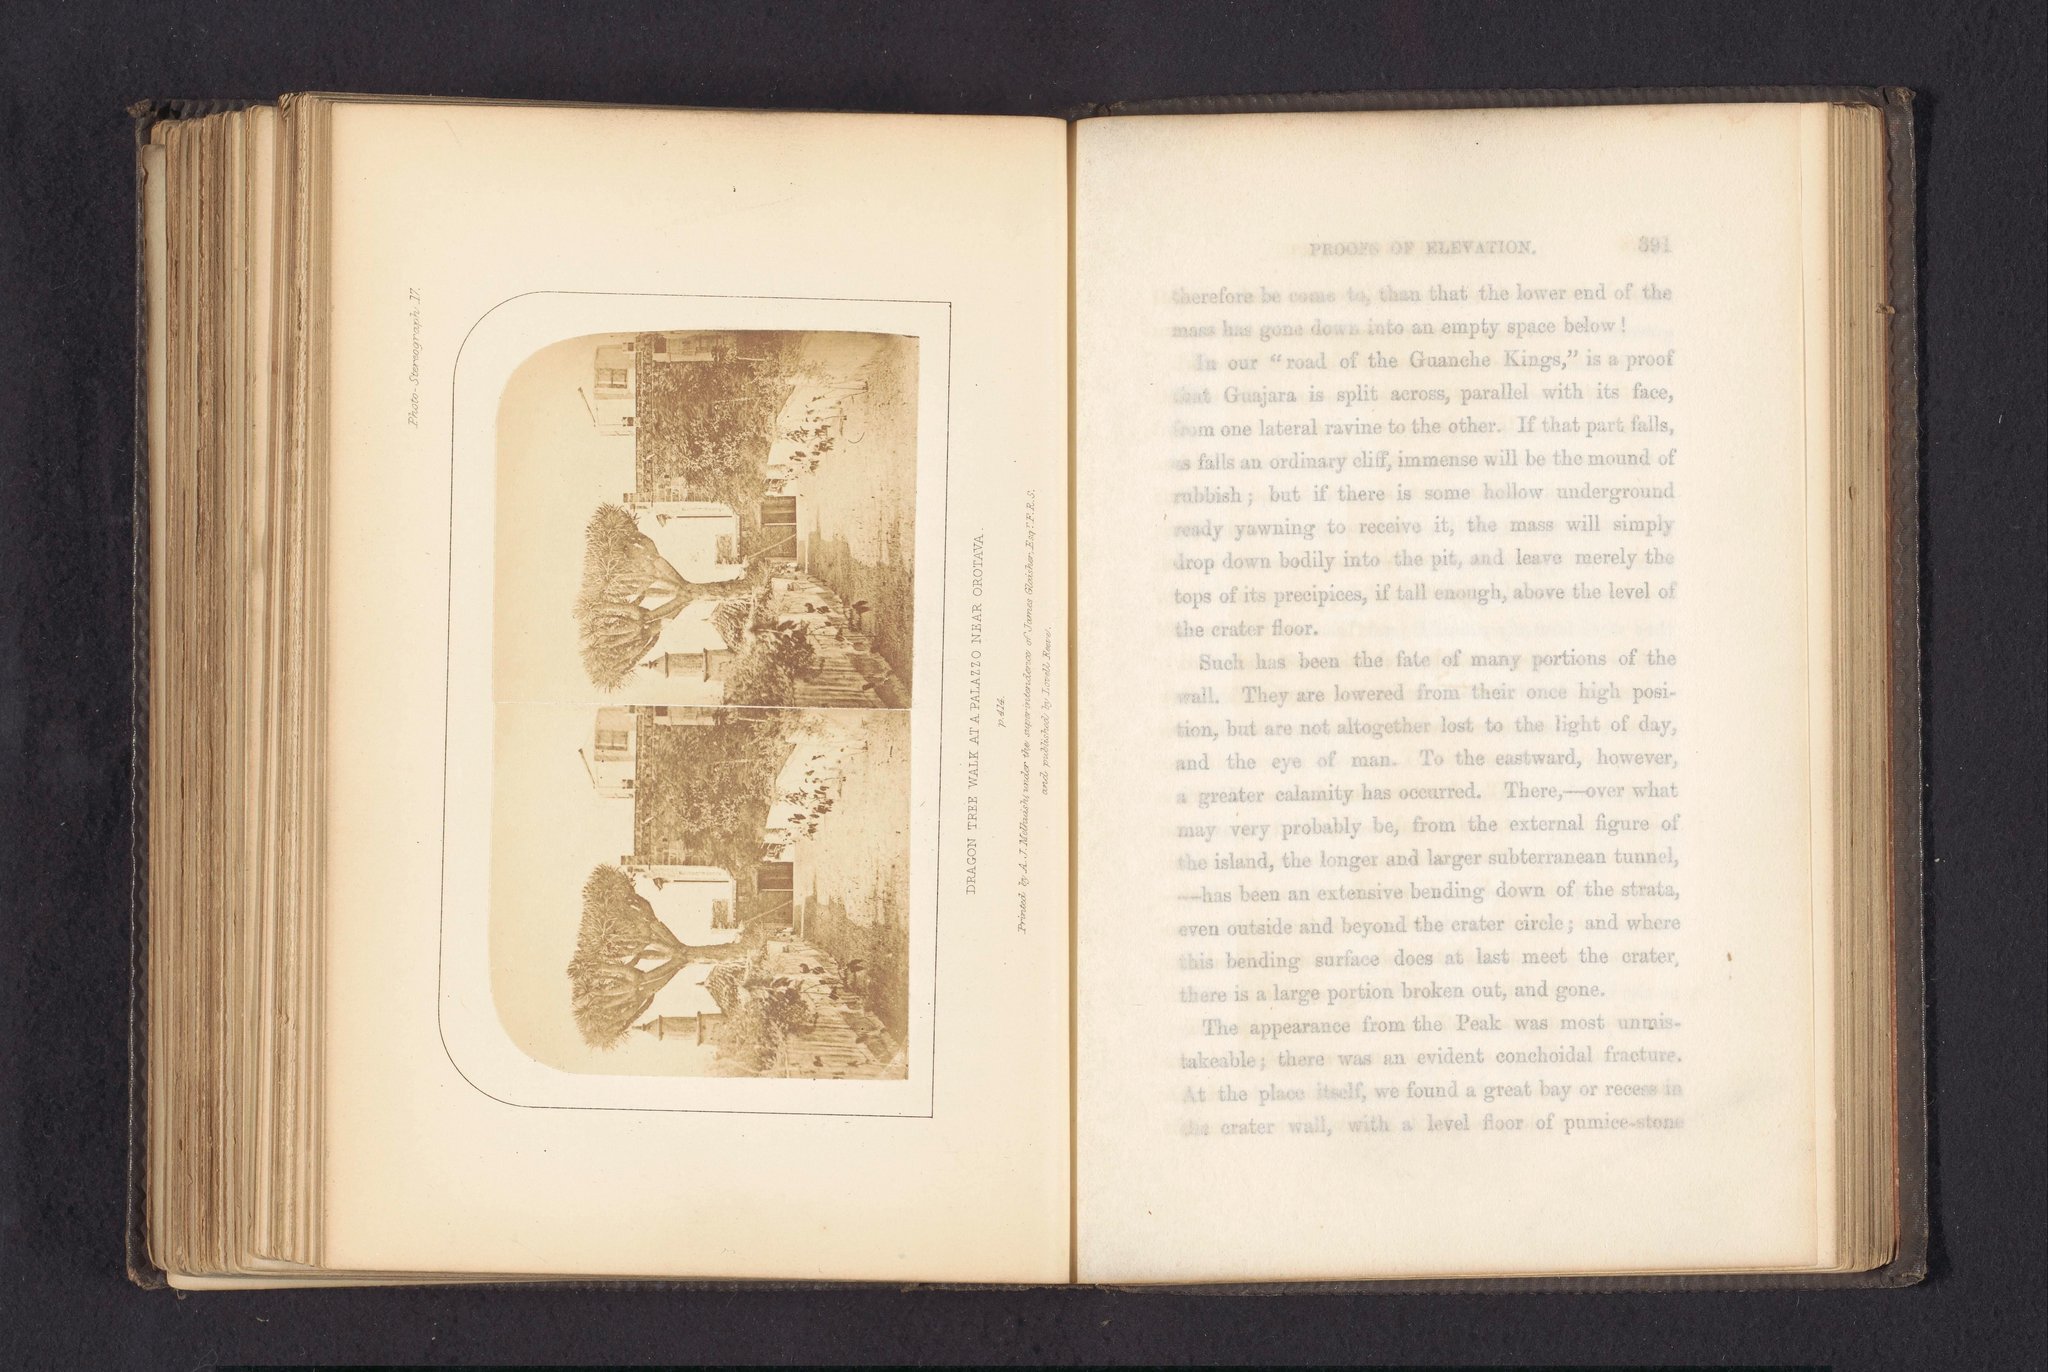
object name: stereograph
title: Dragon tree walk at a palazzo near Orotava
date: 1881-1886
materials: photographic support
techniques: albumen print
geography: la orotava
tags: trees, road, path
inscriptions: number: ‘Photo-stereograph 17.’